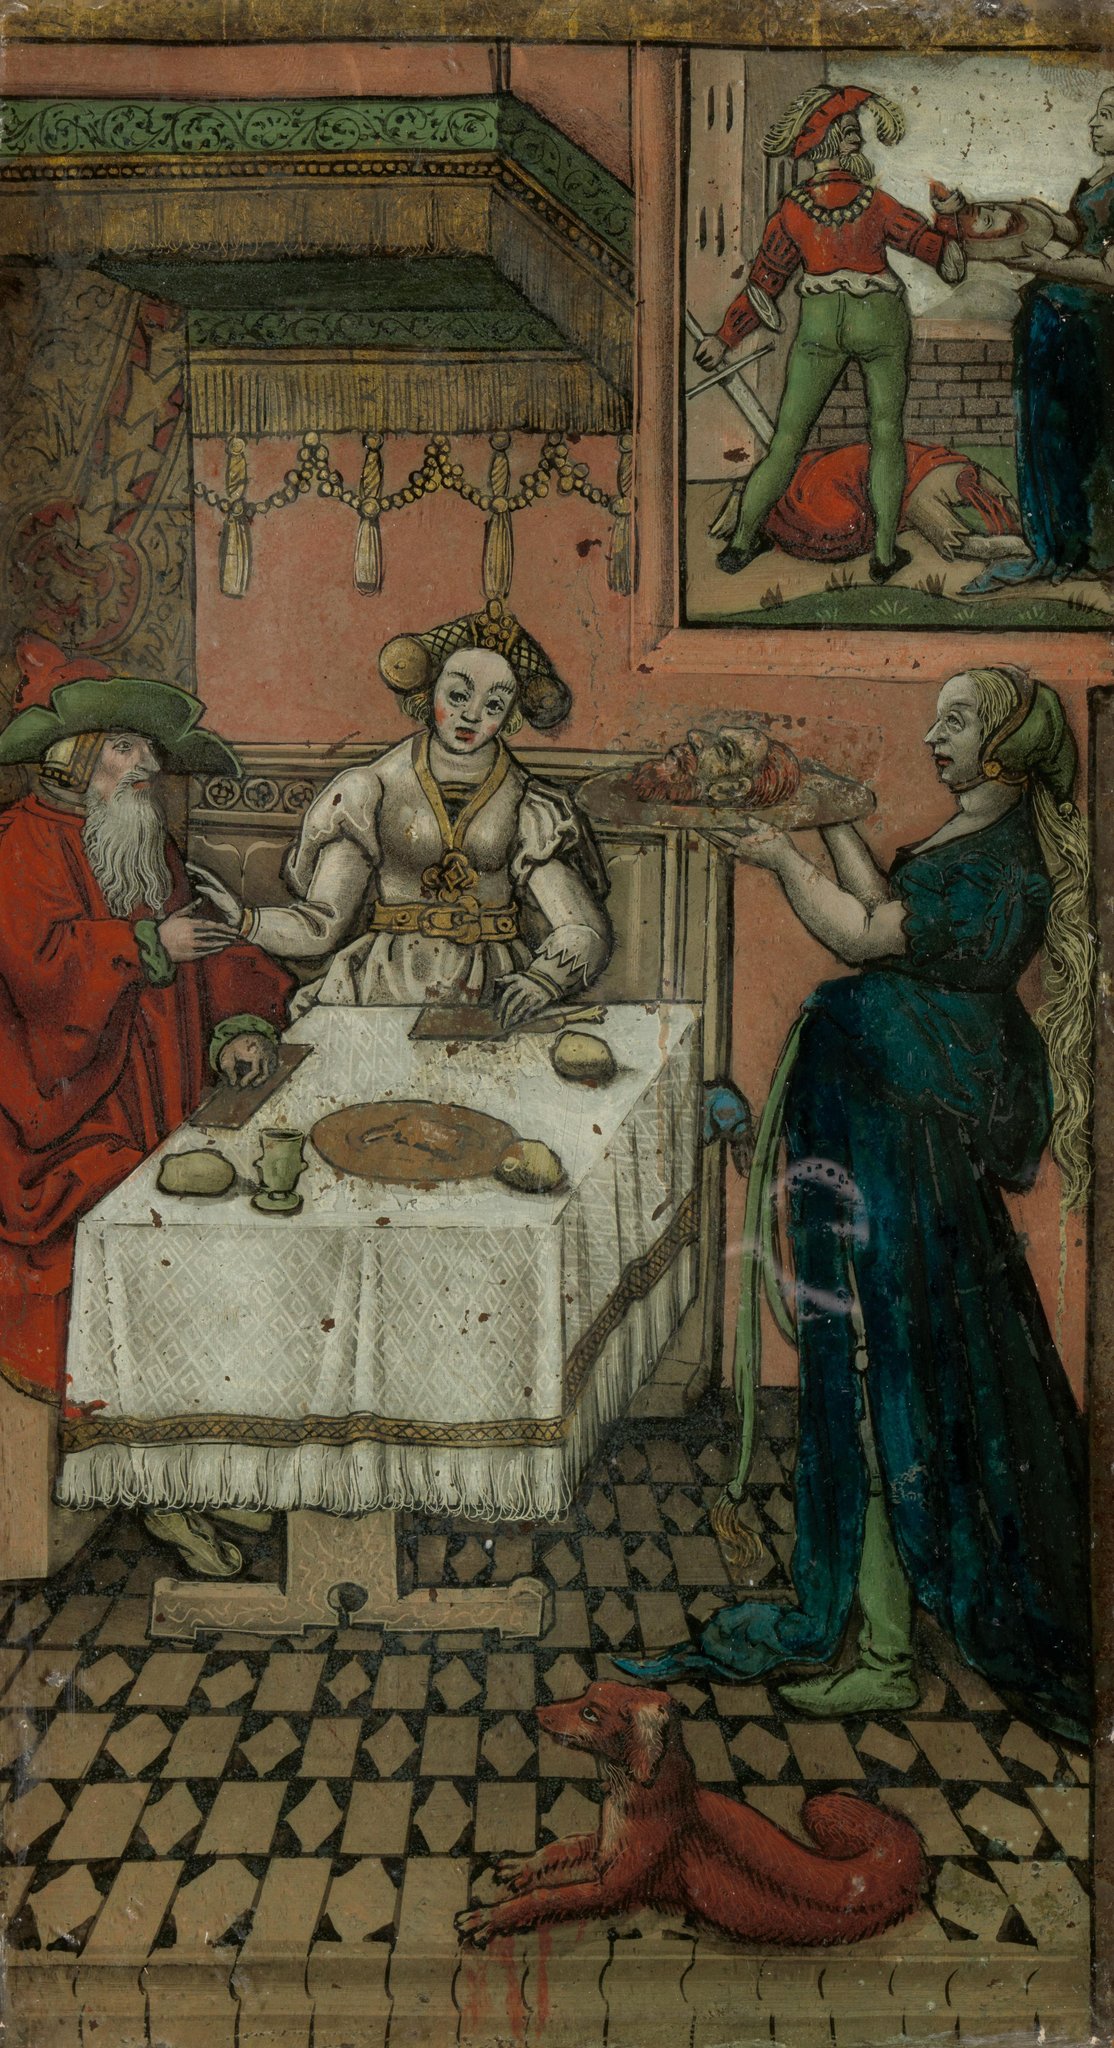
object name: reverse painting on glass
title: Salome with the Head of John the Baptist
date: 1550-1600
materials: glass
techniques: verre églomisé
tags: the head of john the baptist brought to or lying on the banqueting table, salome with the head of john the baptist on a dish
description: Salome met het hoofd van Johannes de Doper. Links zitten Herodes en Herodias onder een baldakijn aan een feestmaal. Op de vloer ligt een hond. Op de achtergrond is door een venster te zien hoe een beul het hoofd van Johannes de Doper aan Salome overhandigt. Kopie naar de houtsnede van Lucas van Leyden.